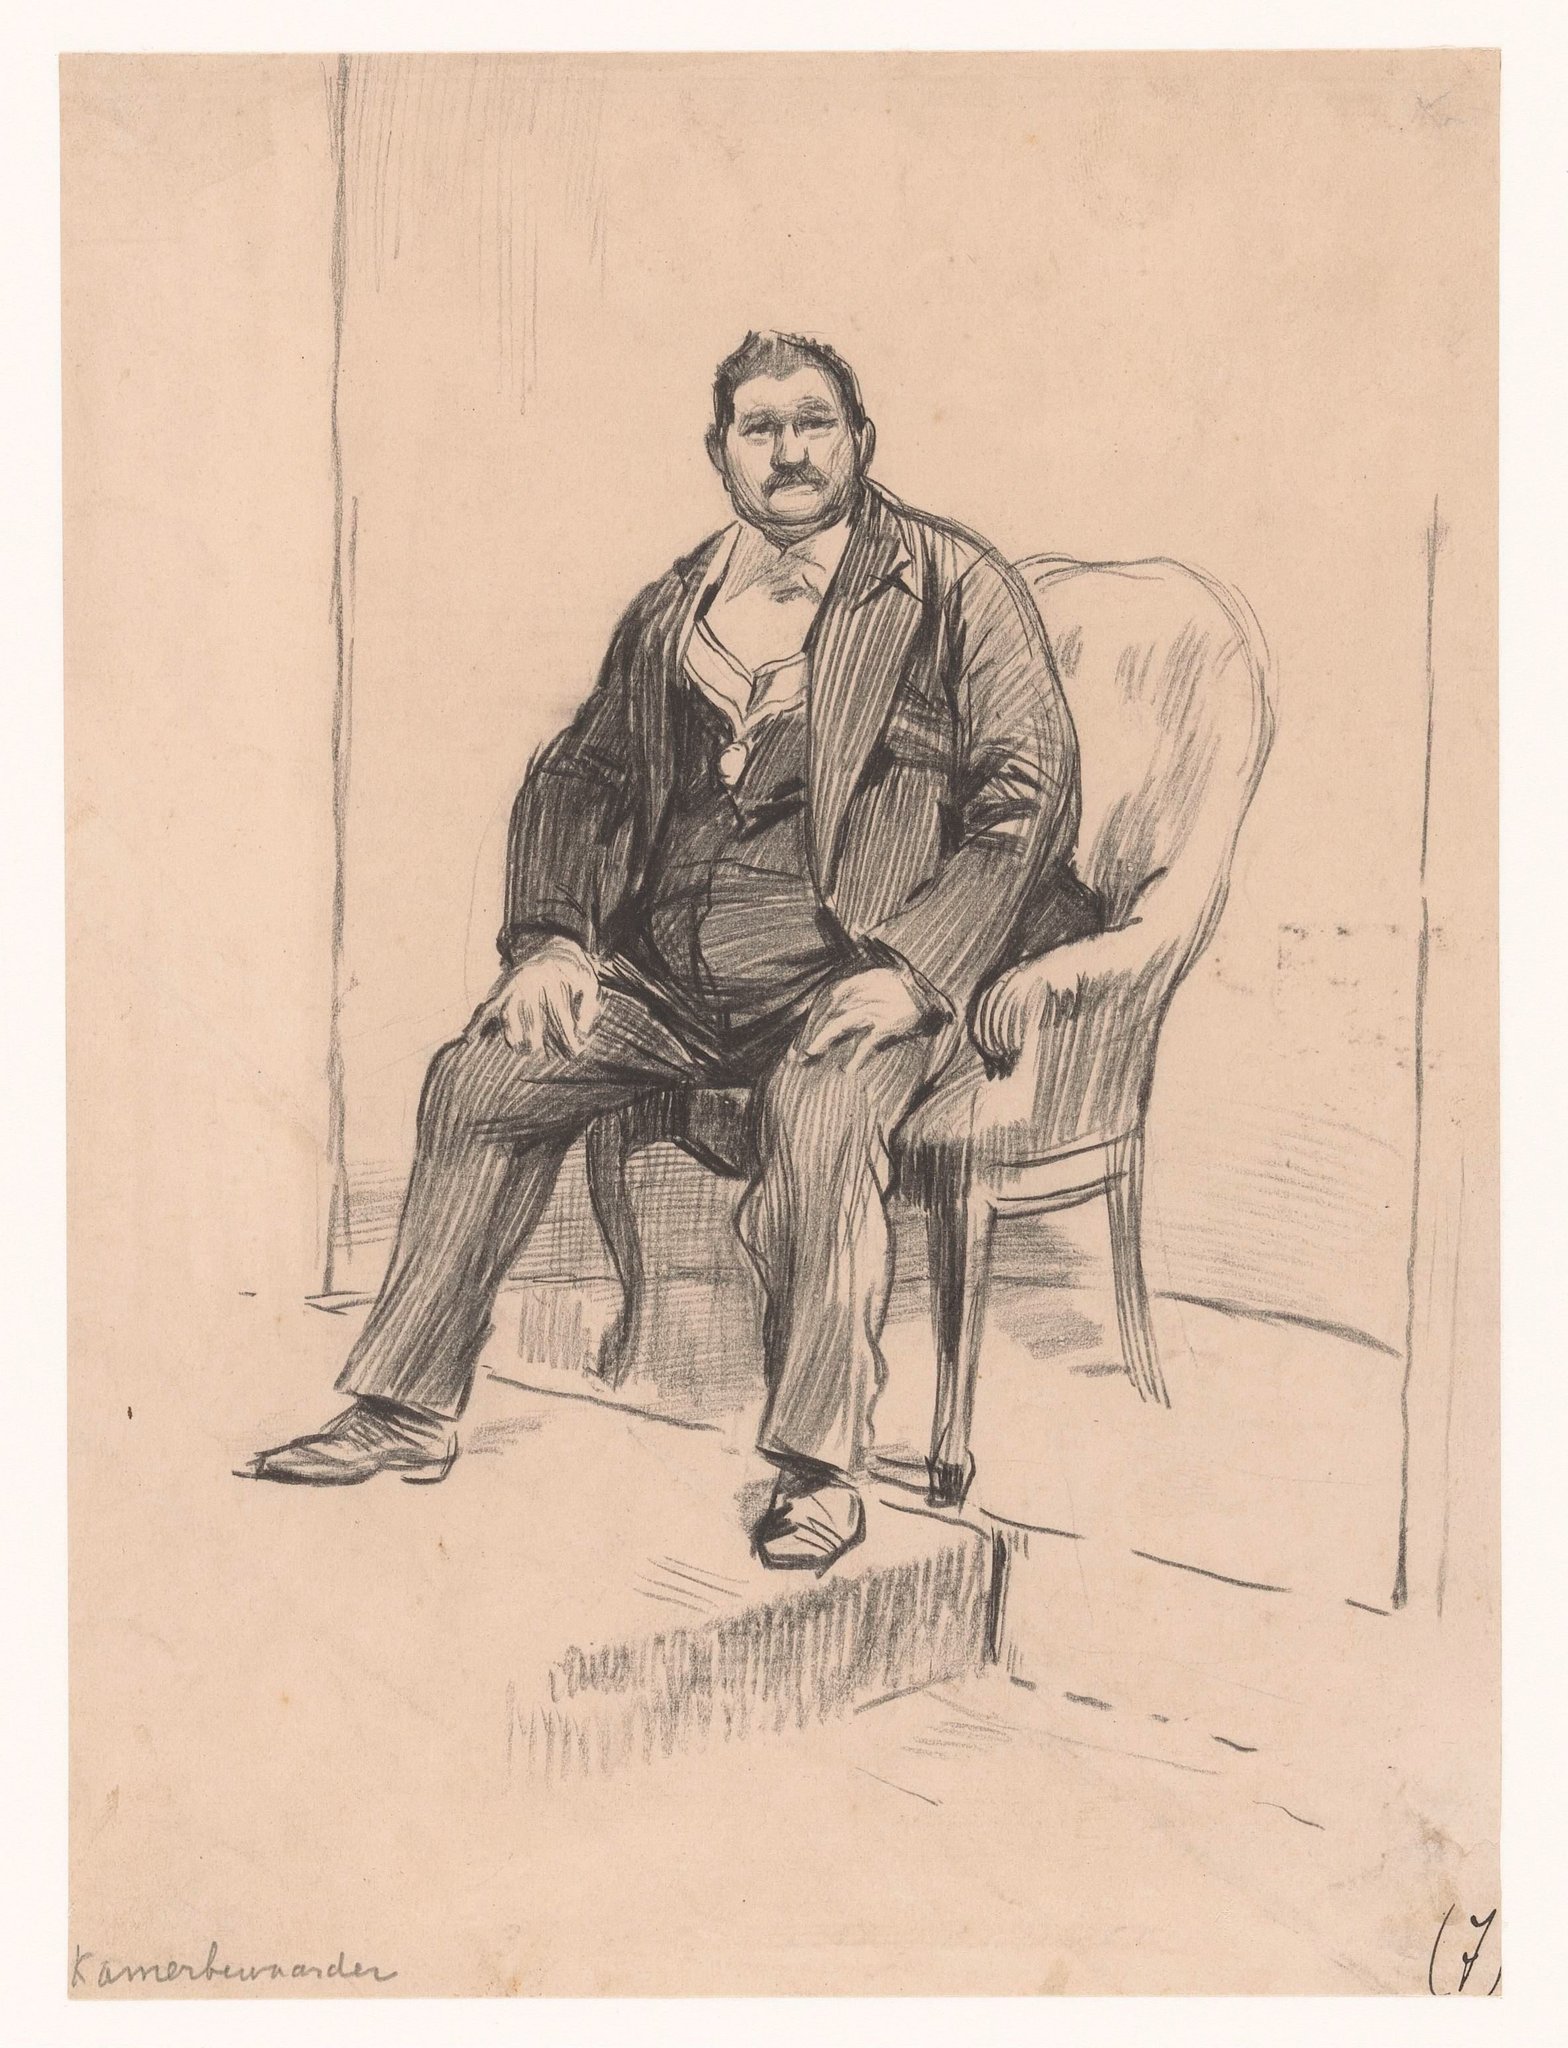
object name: drawing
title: Kamerbewaarder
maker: pieter de josselin de jong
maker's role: draughtsman, painter, print maker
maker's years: 1861-1906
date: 1887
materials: chalk, paper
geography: the hague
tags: anonymous historical person portrayed, netherlands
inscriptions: inscription: ‘Kamerbewaarder / (7)’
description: De kamerbewaarder. Man met fors postuur op stoel zittend op een verhoging. De handen op de knieën, ordeteken op de borst. Onderdeel van een groep schetsen van de bespreking in de Tweede Kamer van de grondwetsherziening van 1887 gepubliceerd in het weekblad Eigen Haard (1887).